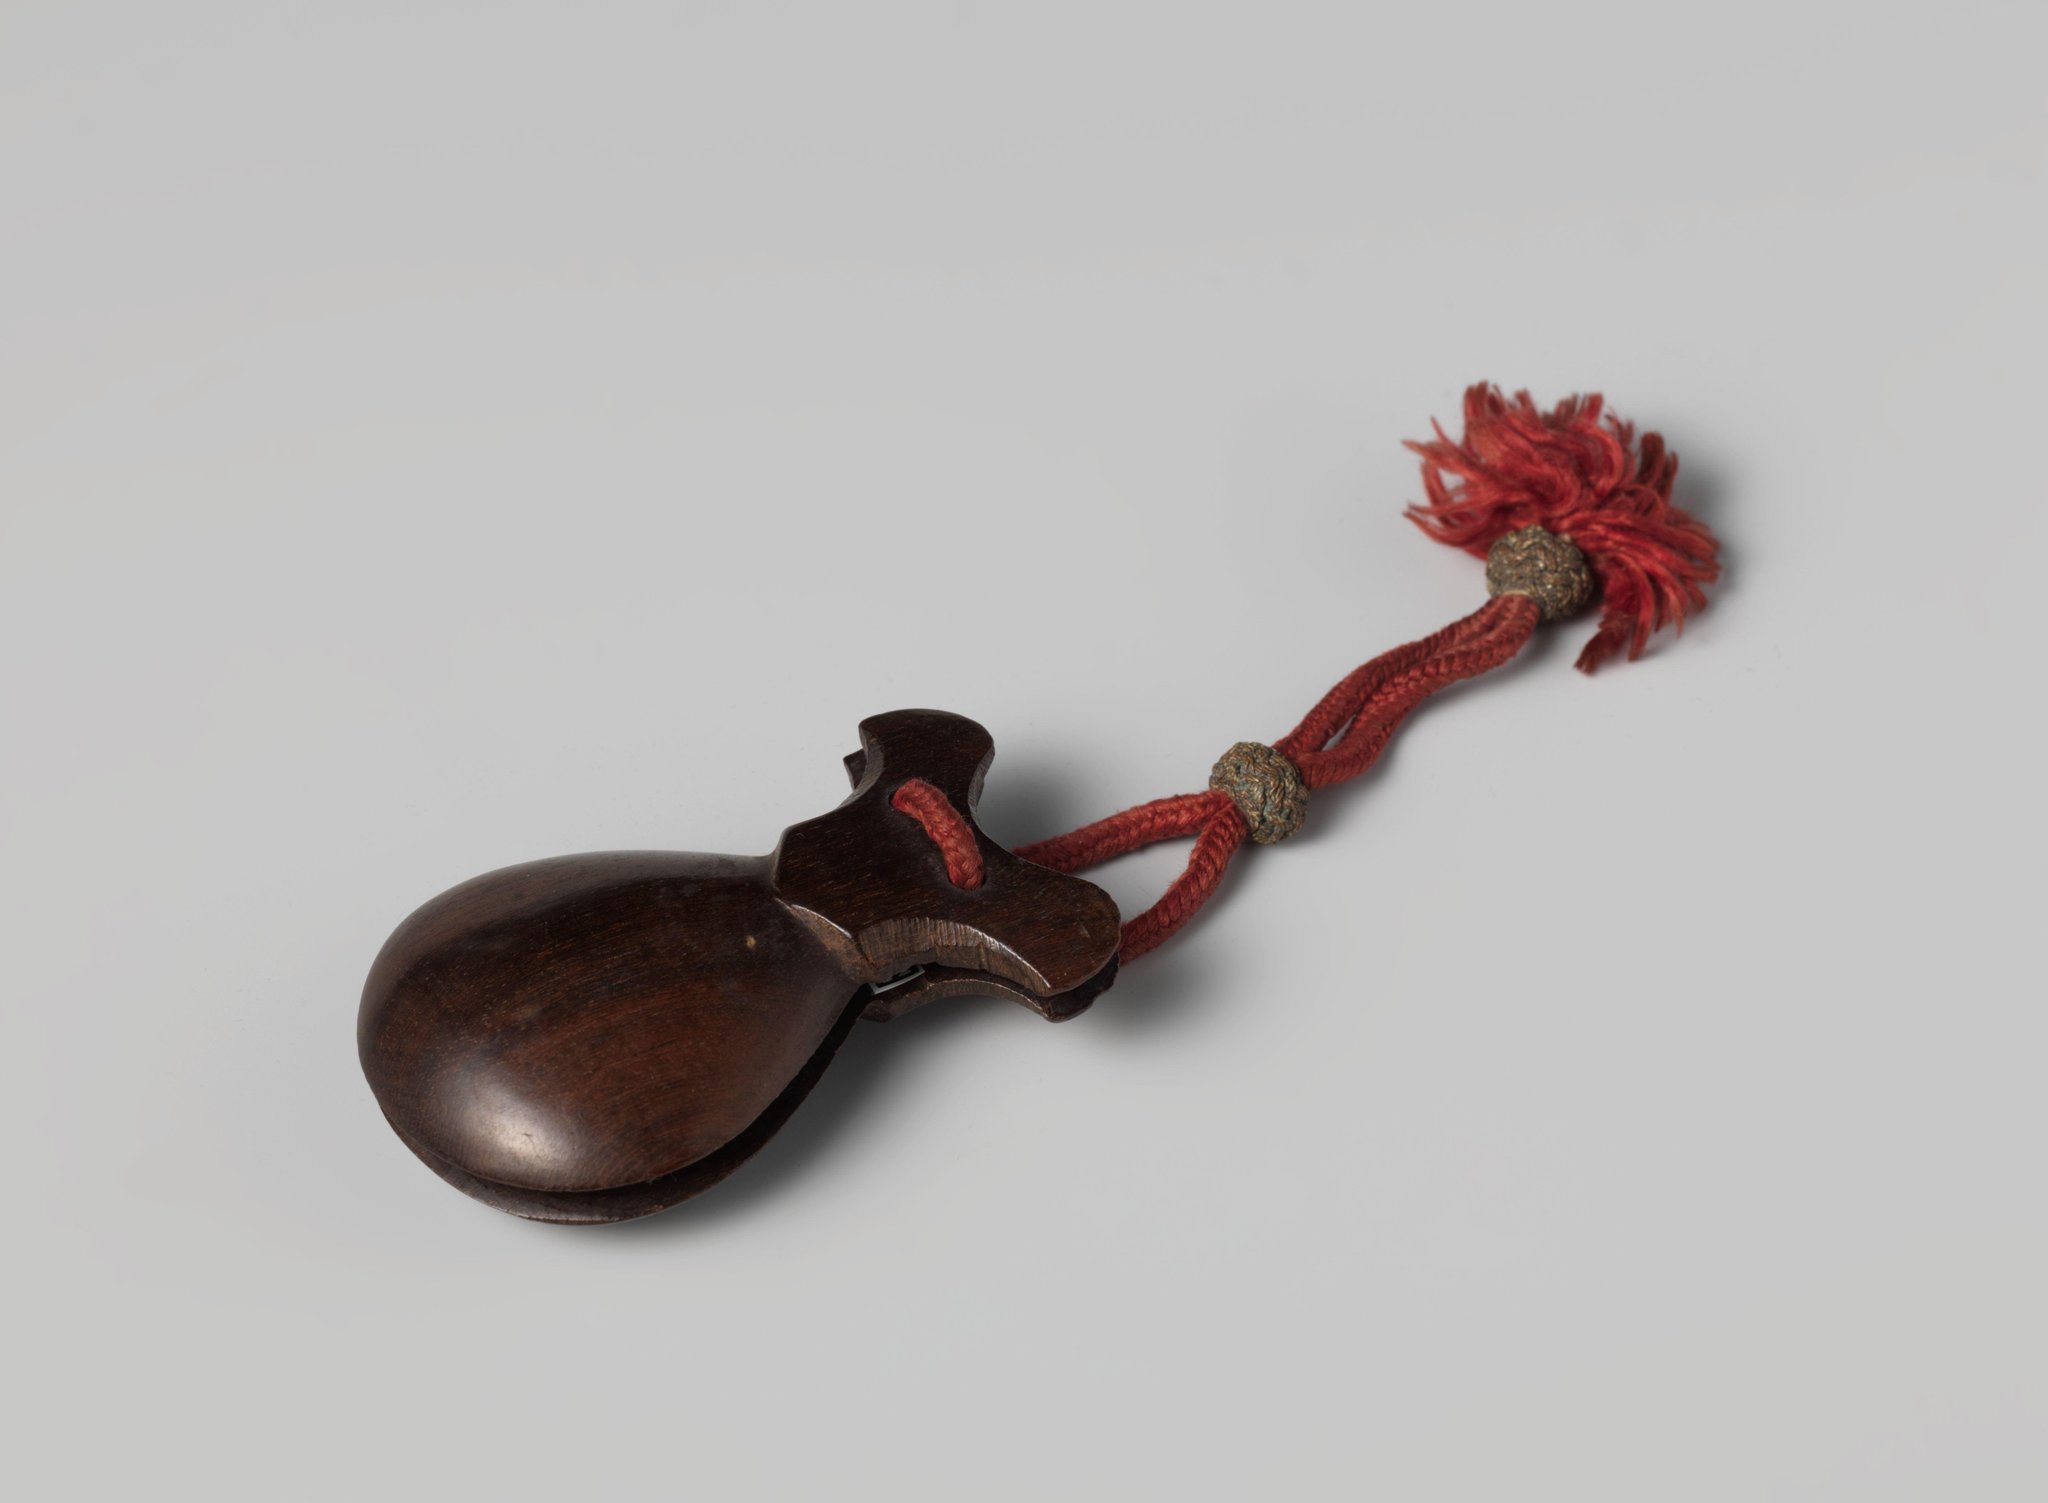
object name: musical instrument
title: Castanets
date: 1800-1822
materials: fiber, wood